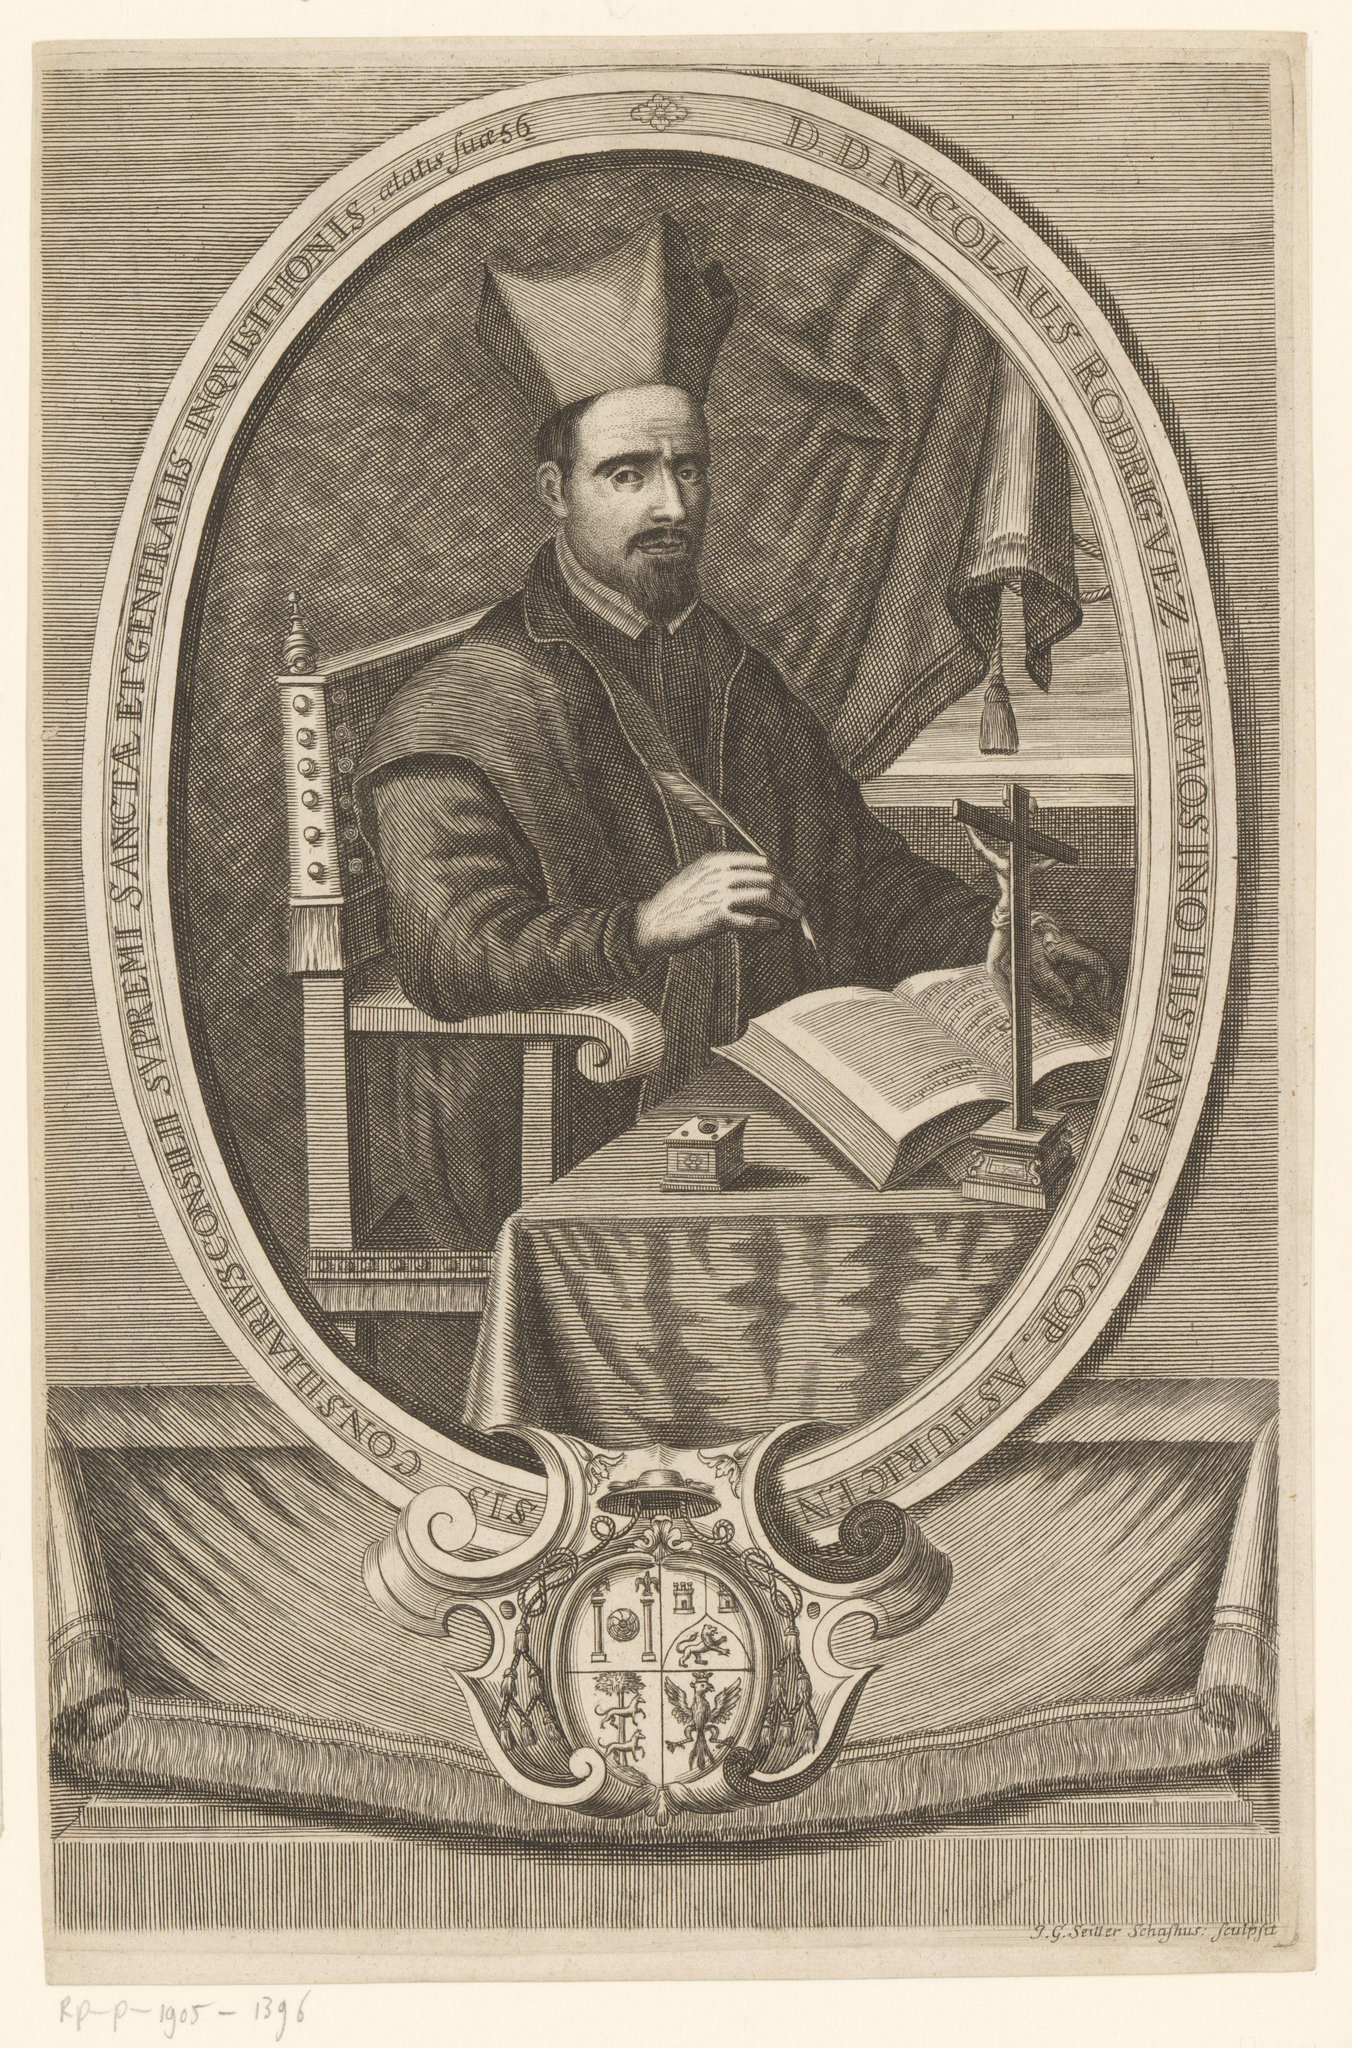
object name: print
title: Portret van Nicolaus Rodriguez Fermosino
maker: johann georg seiller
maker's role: print maker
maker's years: 1663-1740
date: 1673-1740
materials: paper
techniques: engraving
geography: schaffhausen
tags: liturgical vestments, canonicals, historical persons, book, crucifix ~ personal devotion, writing accessories, armorial bearing, heraldry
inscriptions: collector's mark: Lugt 2228